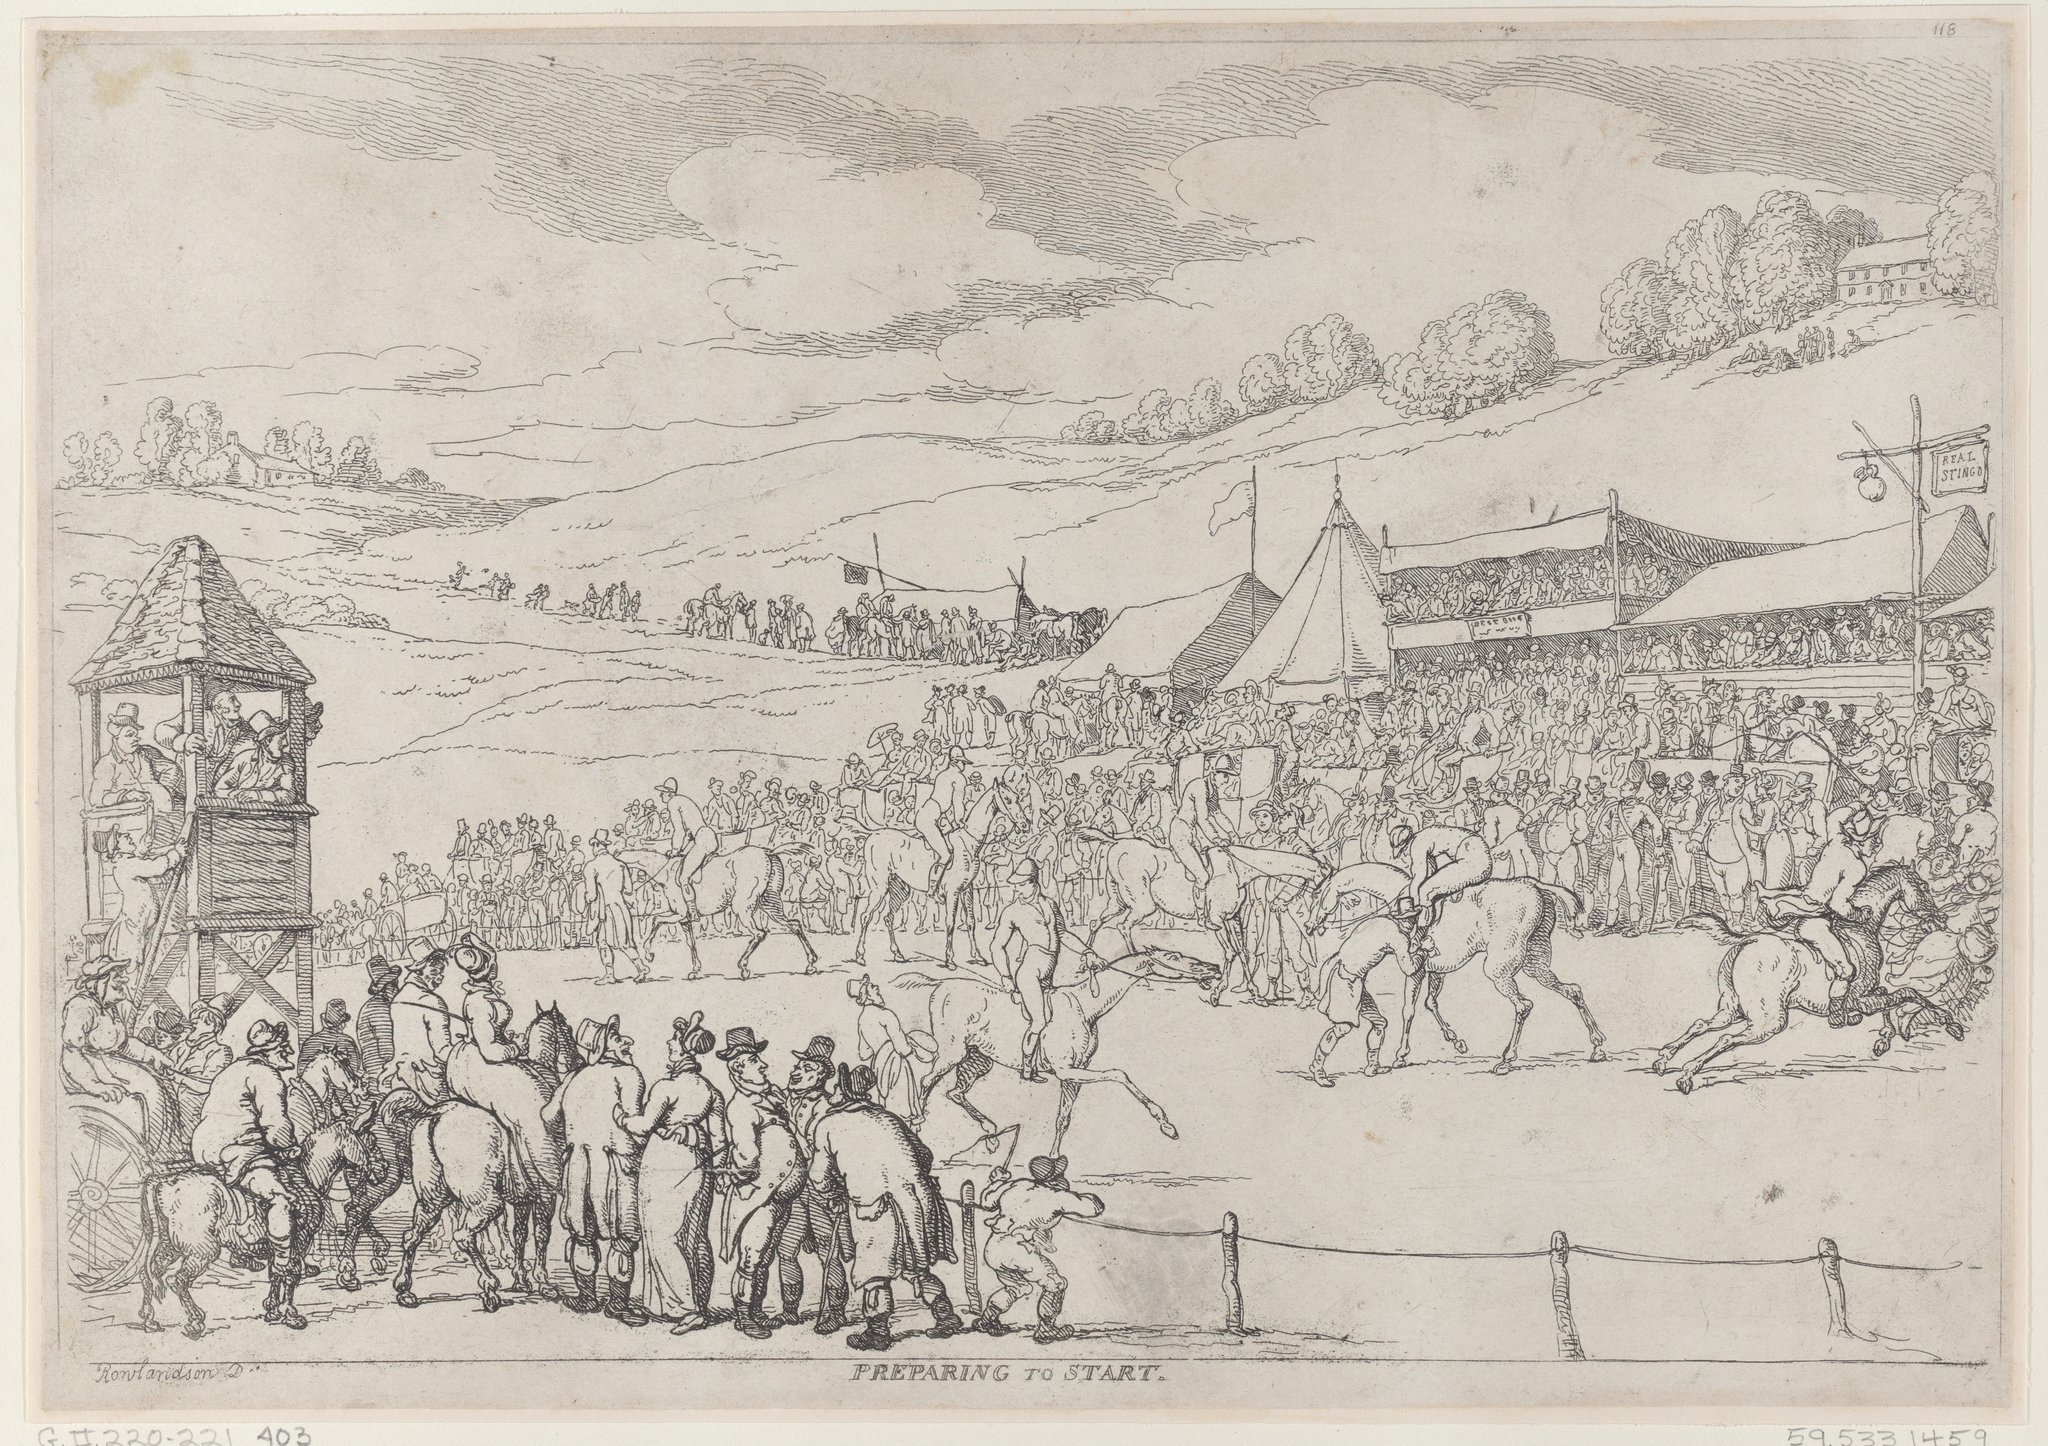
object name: print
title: Preparing to Start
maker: thomas rowlandson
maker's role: artist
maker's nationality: british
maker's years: 1757-1827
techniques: etching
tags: spectators,horses,jockeys